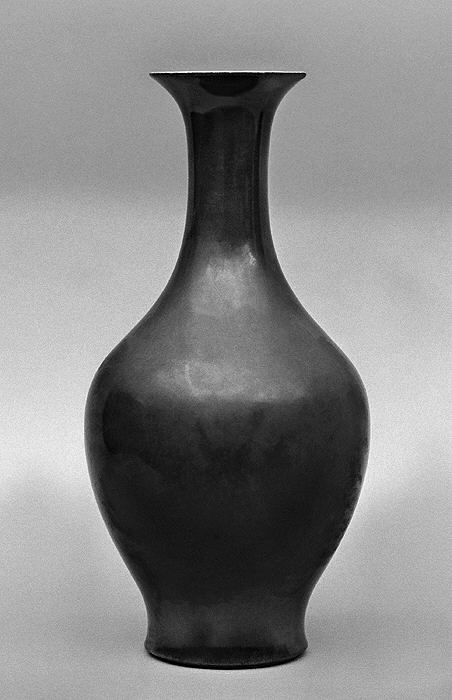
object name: vase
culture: chinese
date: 1701-1800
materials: coral, glaze, porcelain